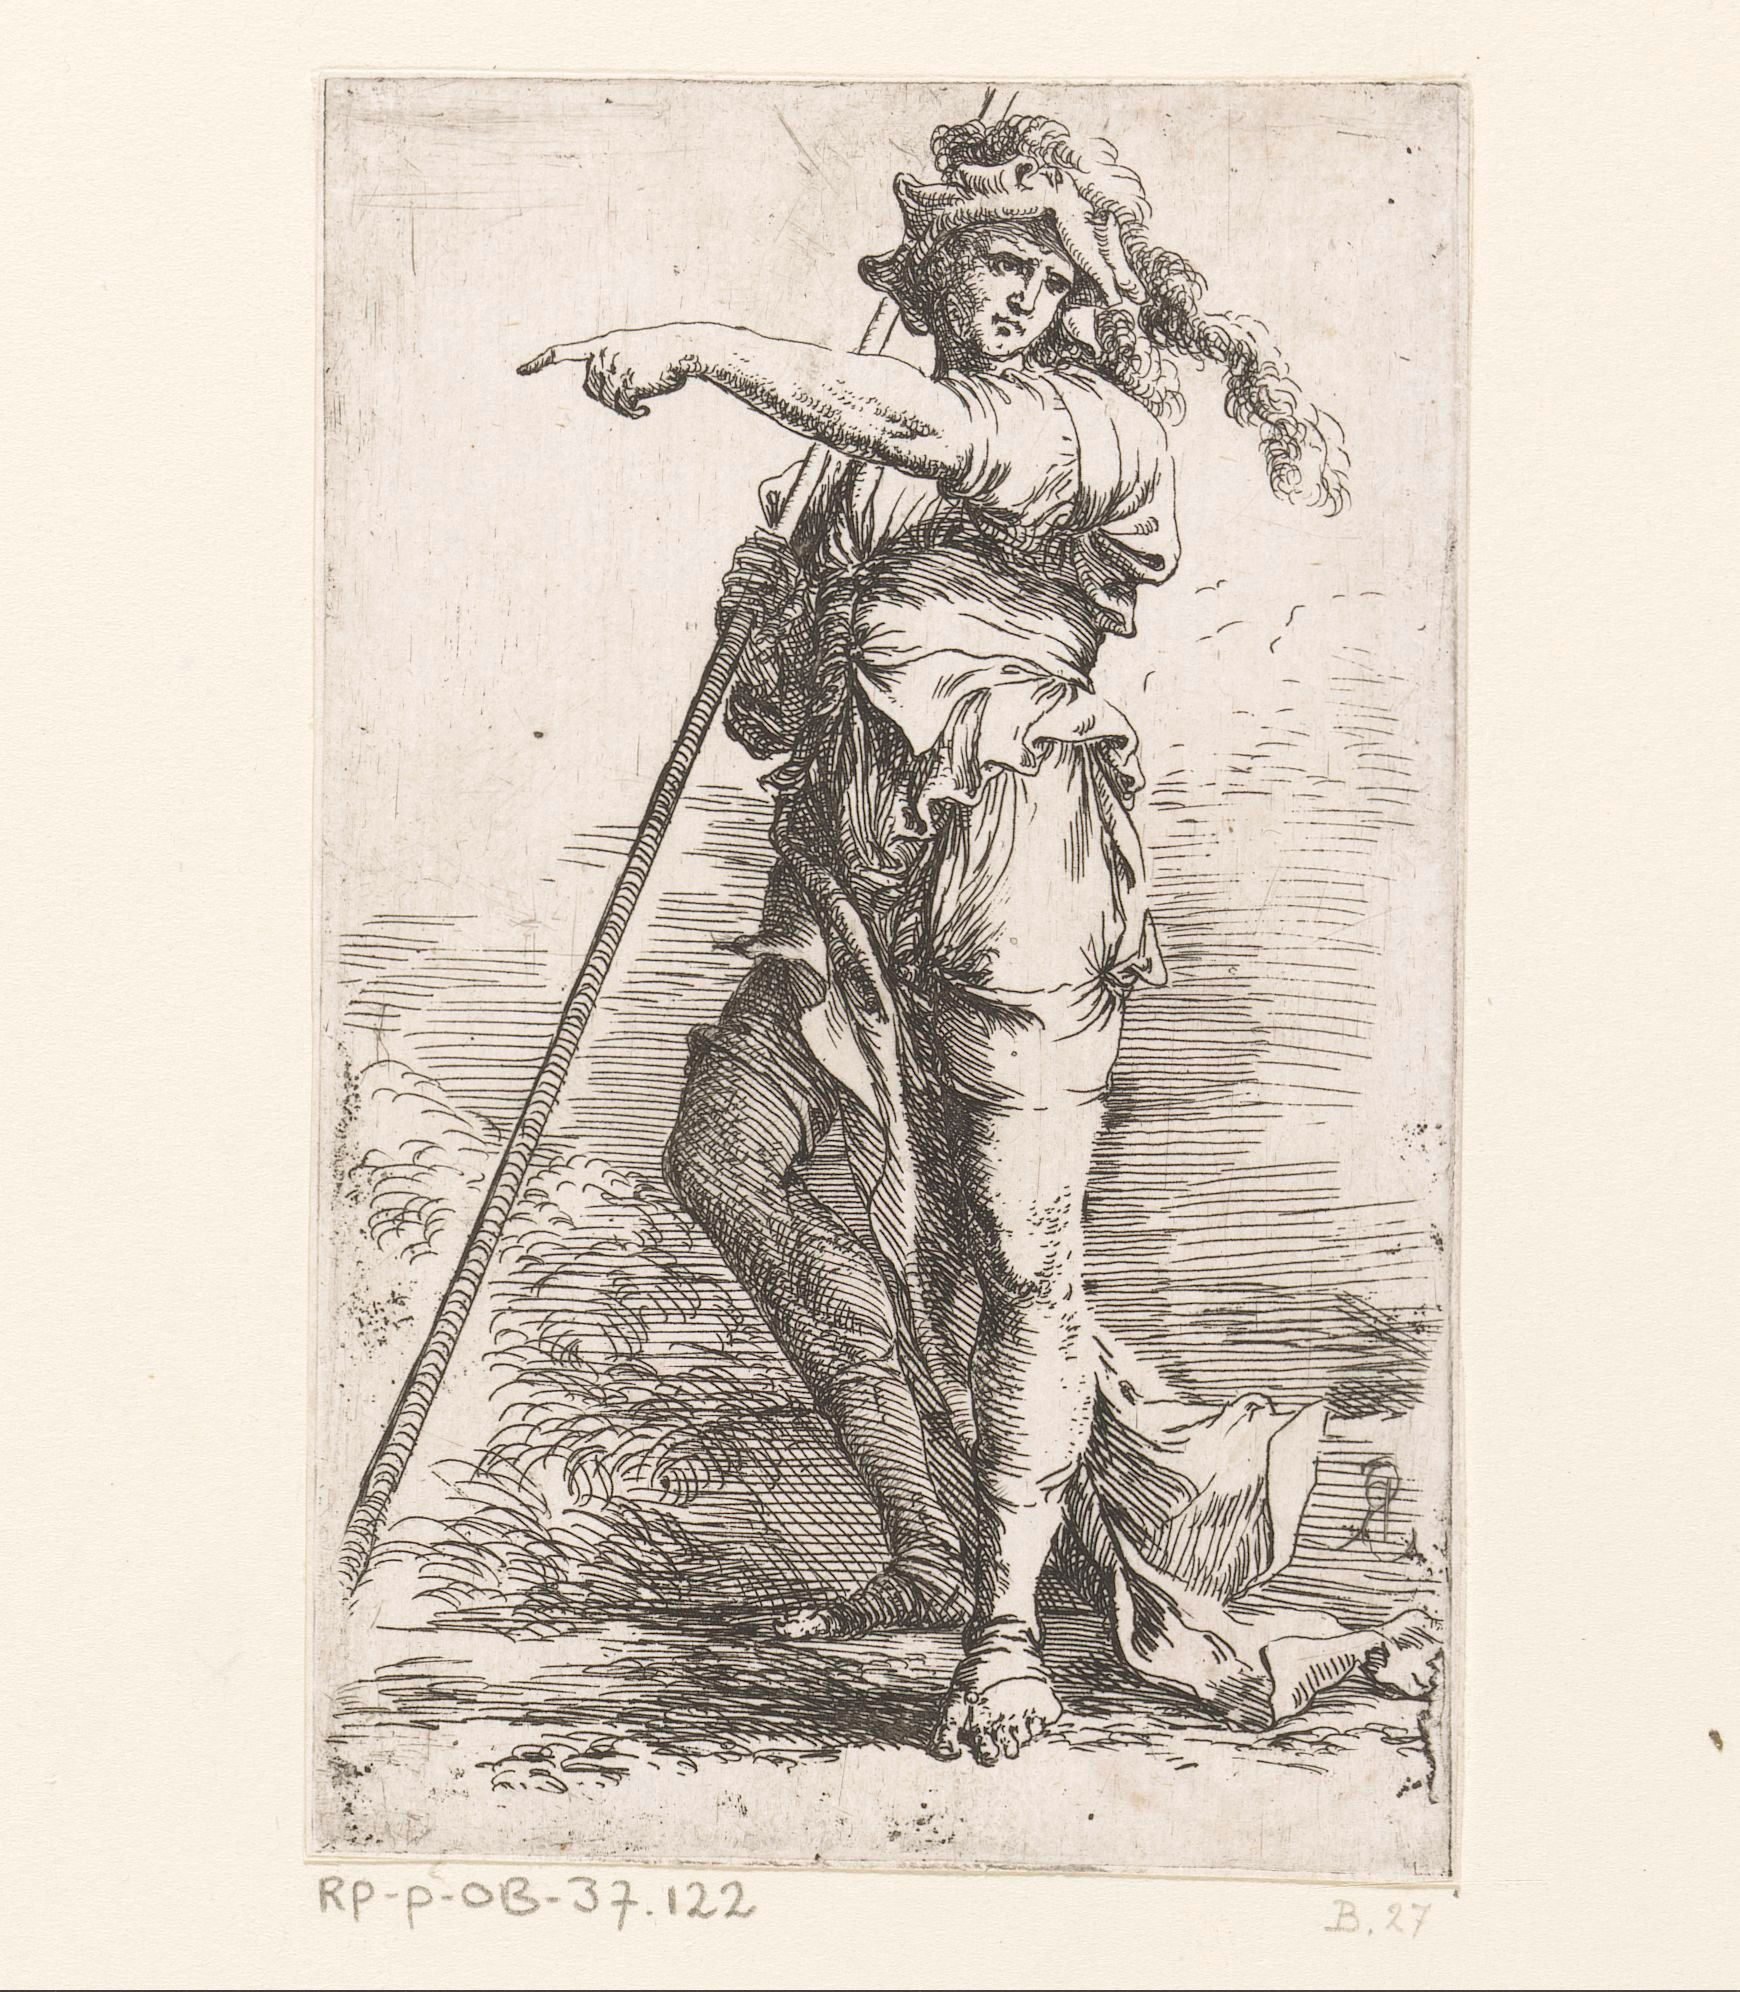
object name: print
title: Figurine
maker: salvator rosa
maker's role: draughtsman, painter, print maker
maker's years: 1615-1673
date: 1656-1657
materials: paper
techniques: drypoint, etching, intaglio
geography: italy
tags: walking-stick, staff, the soldier; the soldier's life, index finger forwards, pointing, indicating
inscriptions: collector's mark: Lugt 240, number: ‘38’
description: Prent naar een tekening die zich eens bevond in de collectie van Ladislao Odescalchi te Rome (mogelijk bevindt de tekening zich niet meer in deze collectie). Deze prent maakt deel uit van de serie 'Figurine', bestaande uit een titelprent en 80 prenten van klein formaat met voorstellingen van mannelijke en vrouwelijke figuren. Rosa produceerde de serie waarschijnlijk gedurende de jaren 1656 en 1657.